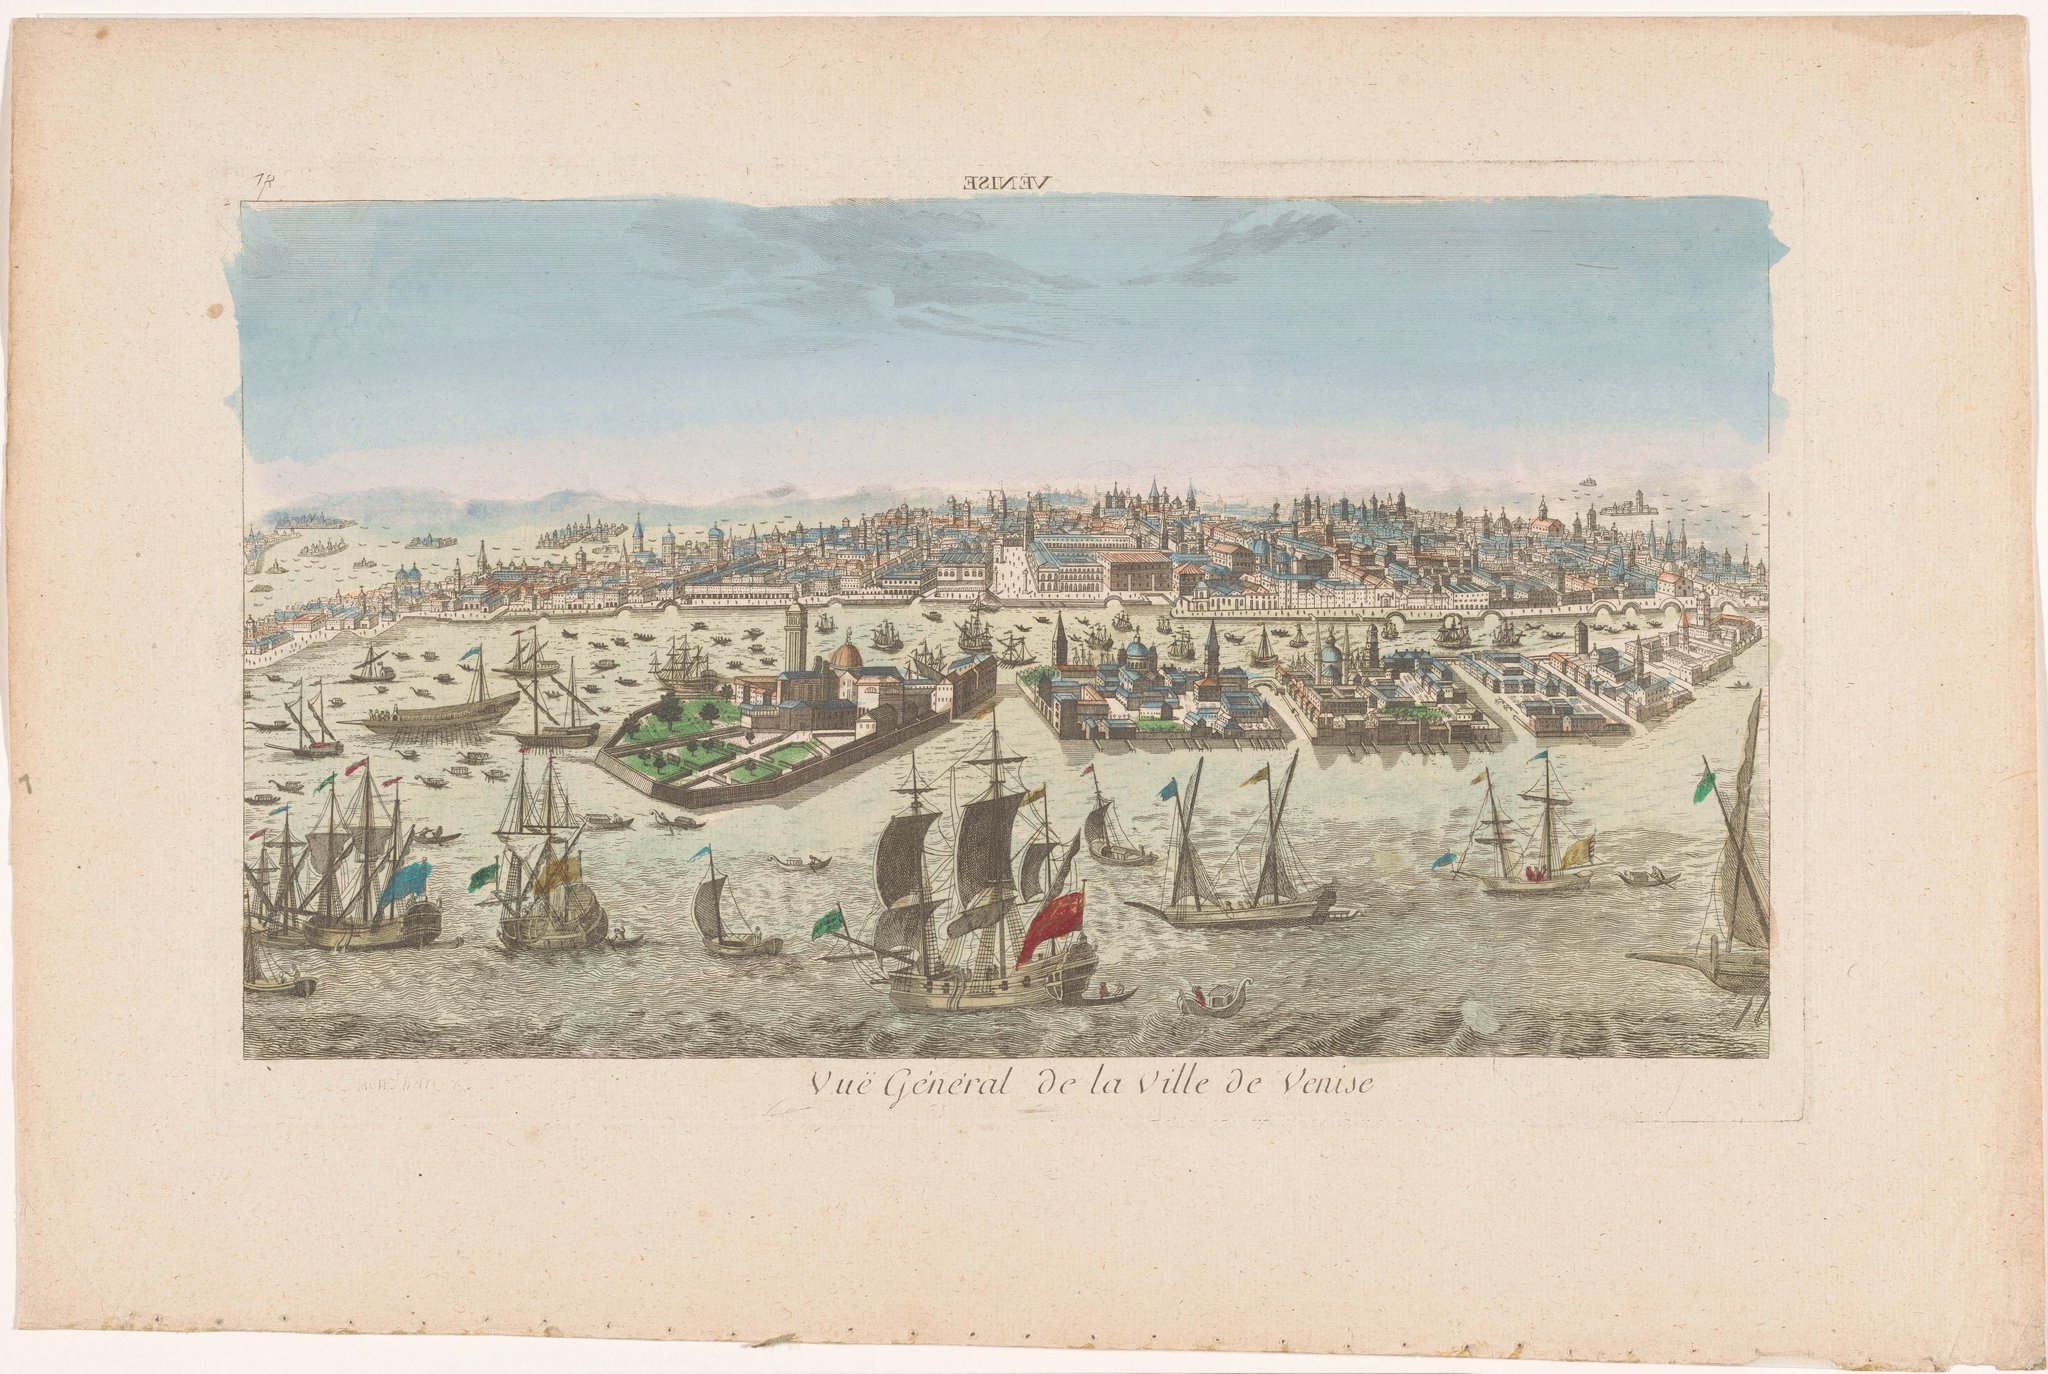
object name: opticaprent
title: Vuë général de la ville de Venise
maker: Anonymous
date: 1700-1799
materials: paper, watercolor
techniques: brush, etching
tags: sailing-ship, sailing-boat, gondola, city-view in general; 'veduta' (+ city(-scape) with figures, staffage), venice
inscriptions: watermark, collector's mark: Lugt 2166